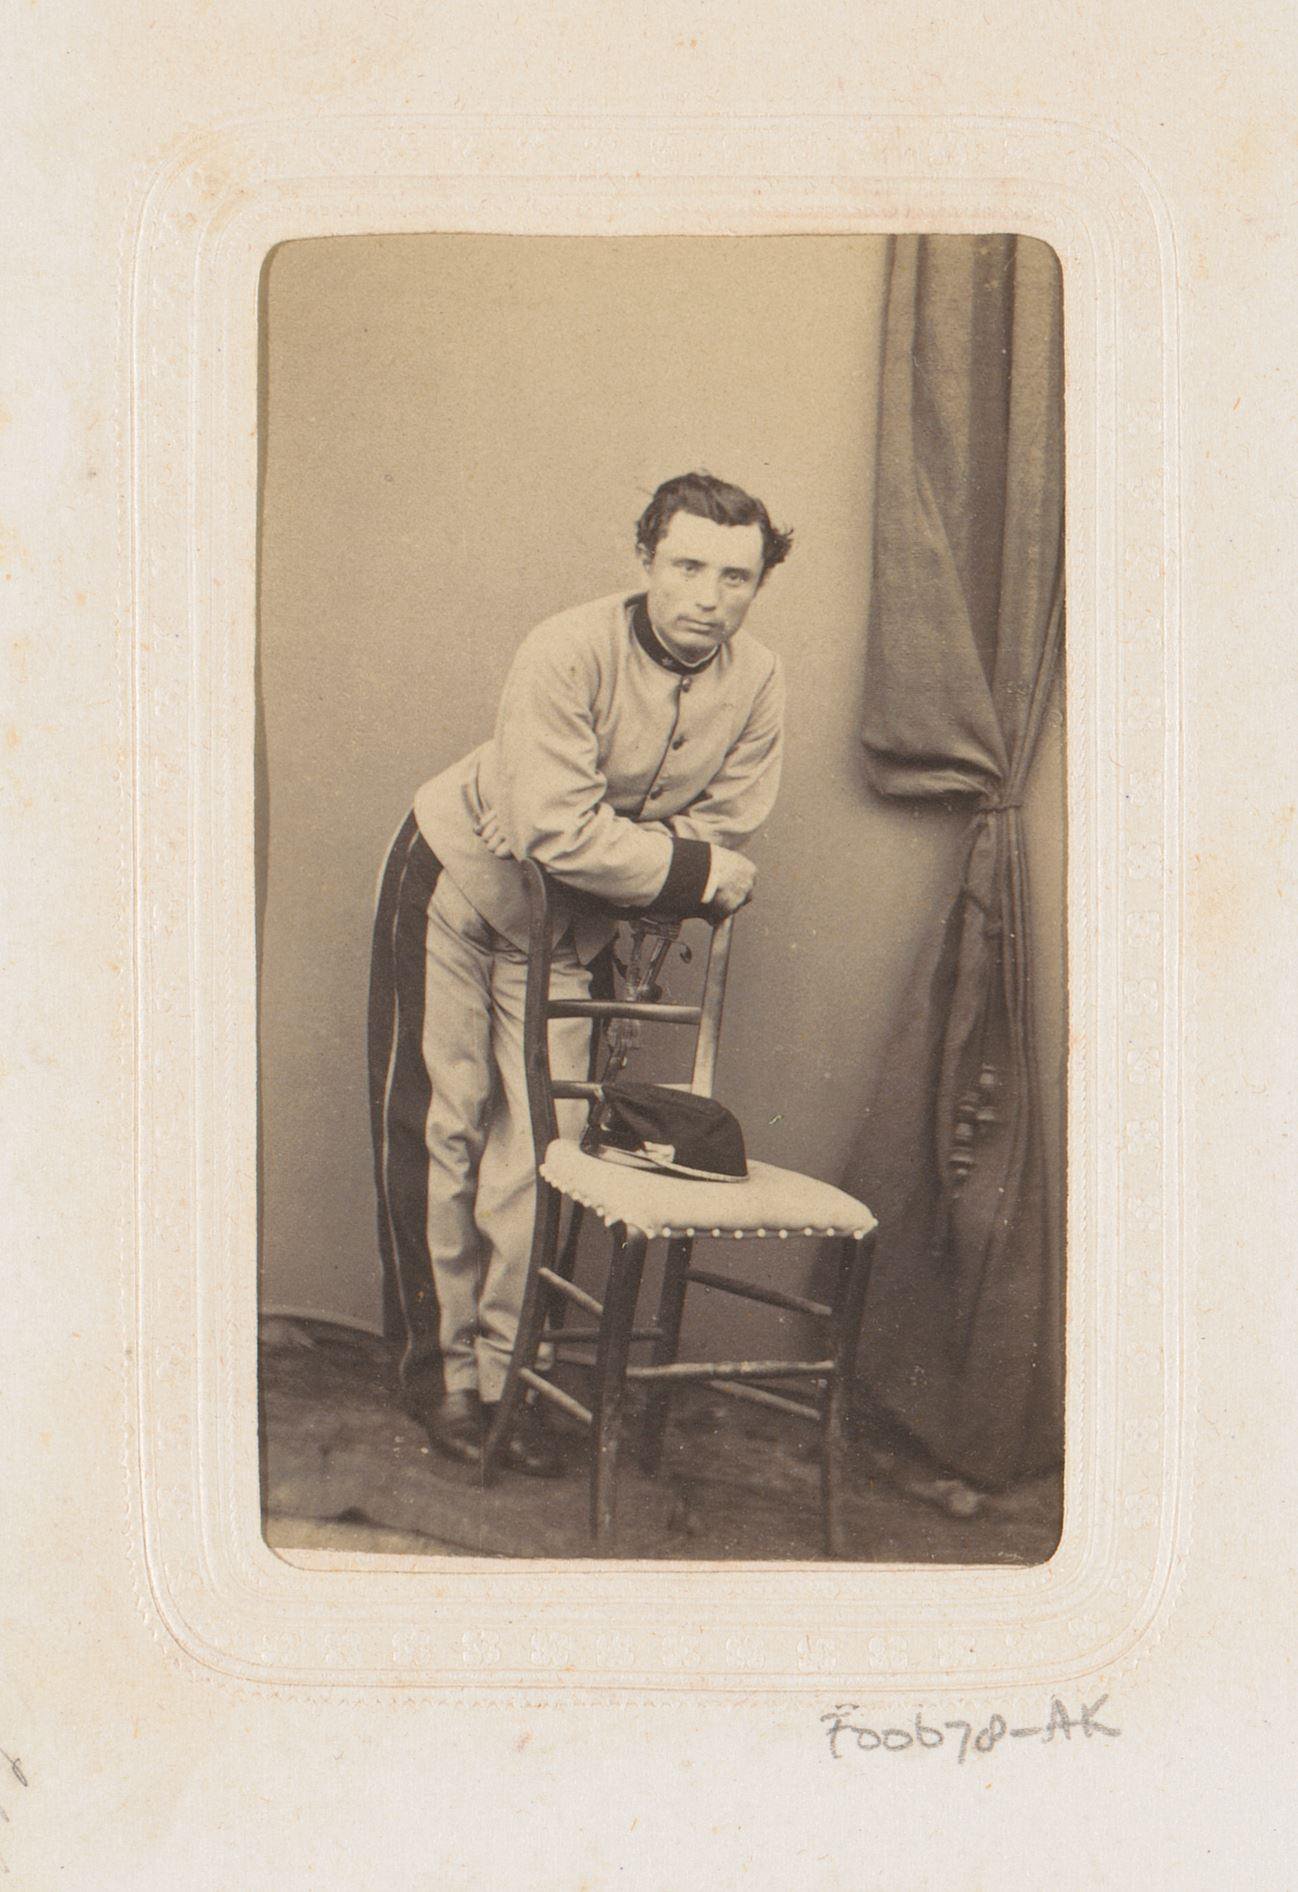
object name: photograph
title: Portret van een staande militair leunend op een stoel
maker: Anonymous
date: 1860-1880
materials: cardboard, photographic support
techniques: albumen print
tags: historical persons, (military) uniforms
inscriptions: annotation: ‘Salzburg’